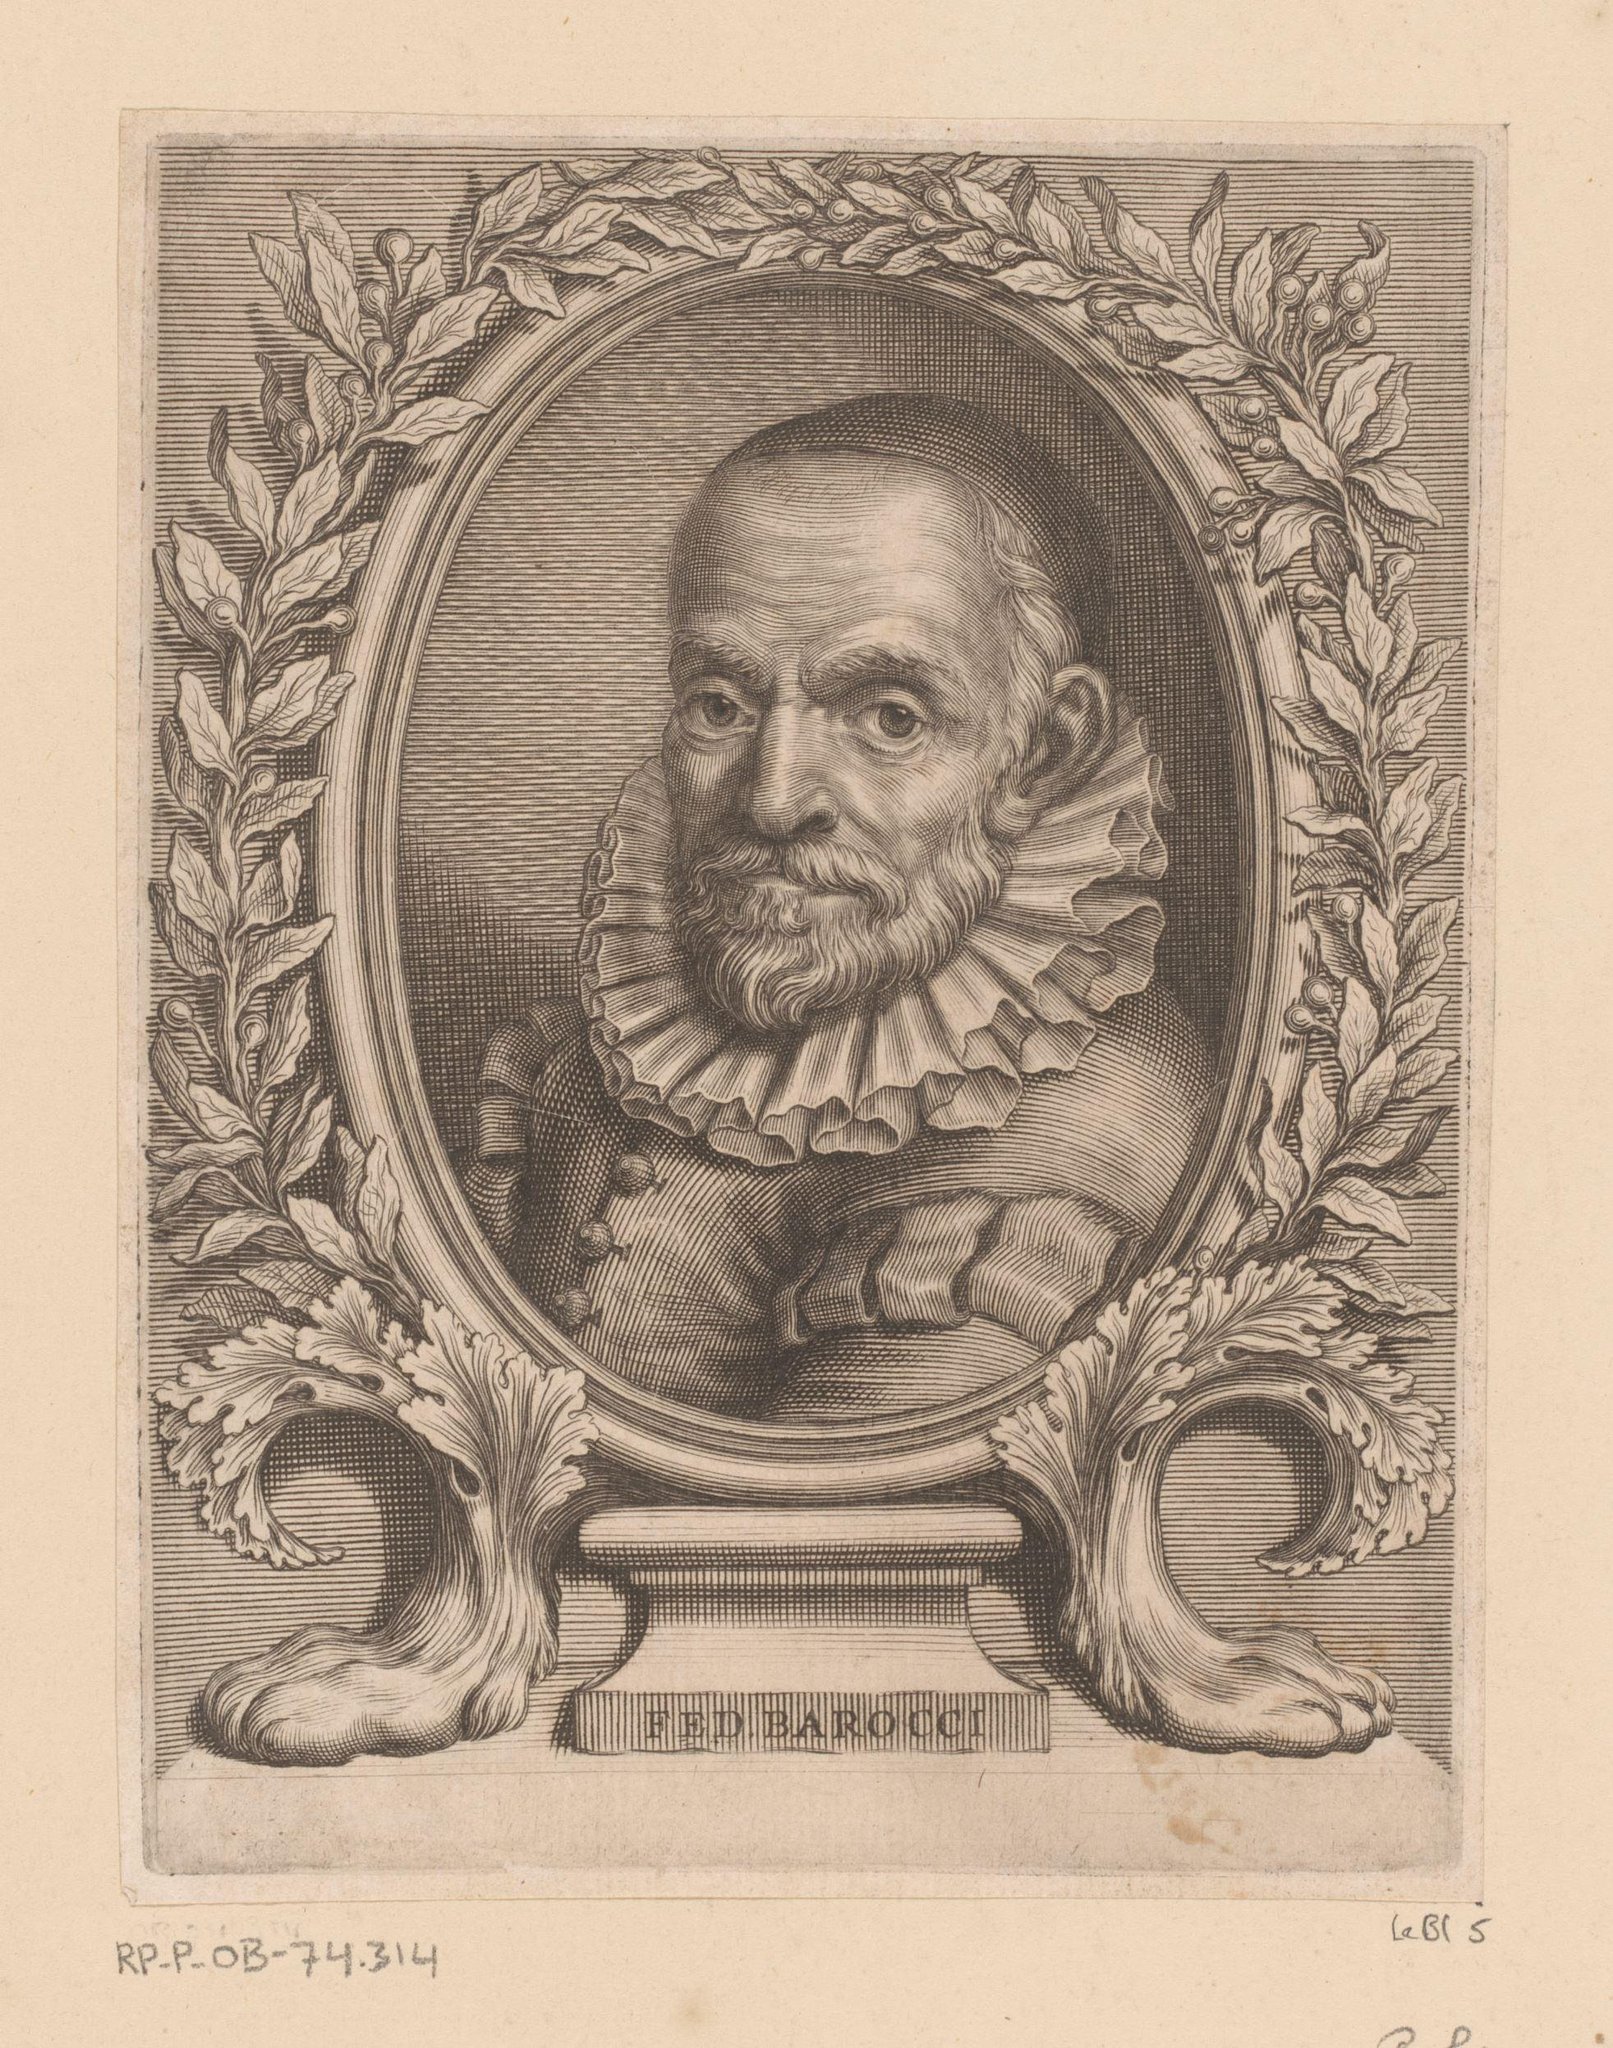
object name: print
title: Portret van Federico Barocci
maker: pierre simon (i)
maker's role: print maker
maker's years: 1640-1710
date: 1645-1715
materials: paper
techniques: engraving, etching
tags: painter, print maker, draughtsman, federico barocci, historical persons, portrait, self-portrait of painter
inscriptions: collector's mark: Lugt 240